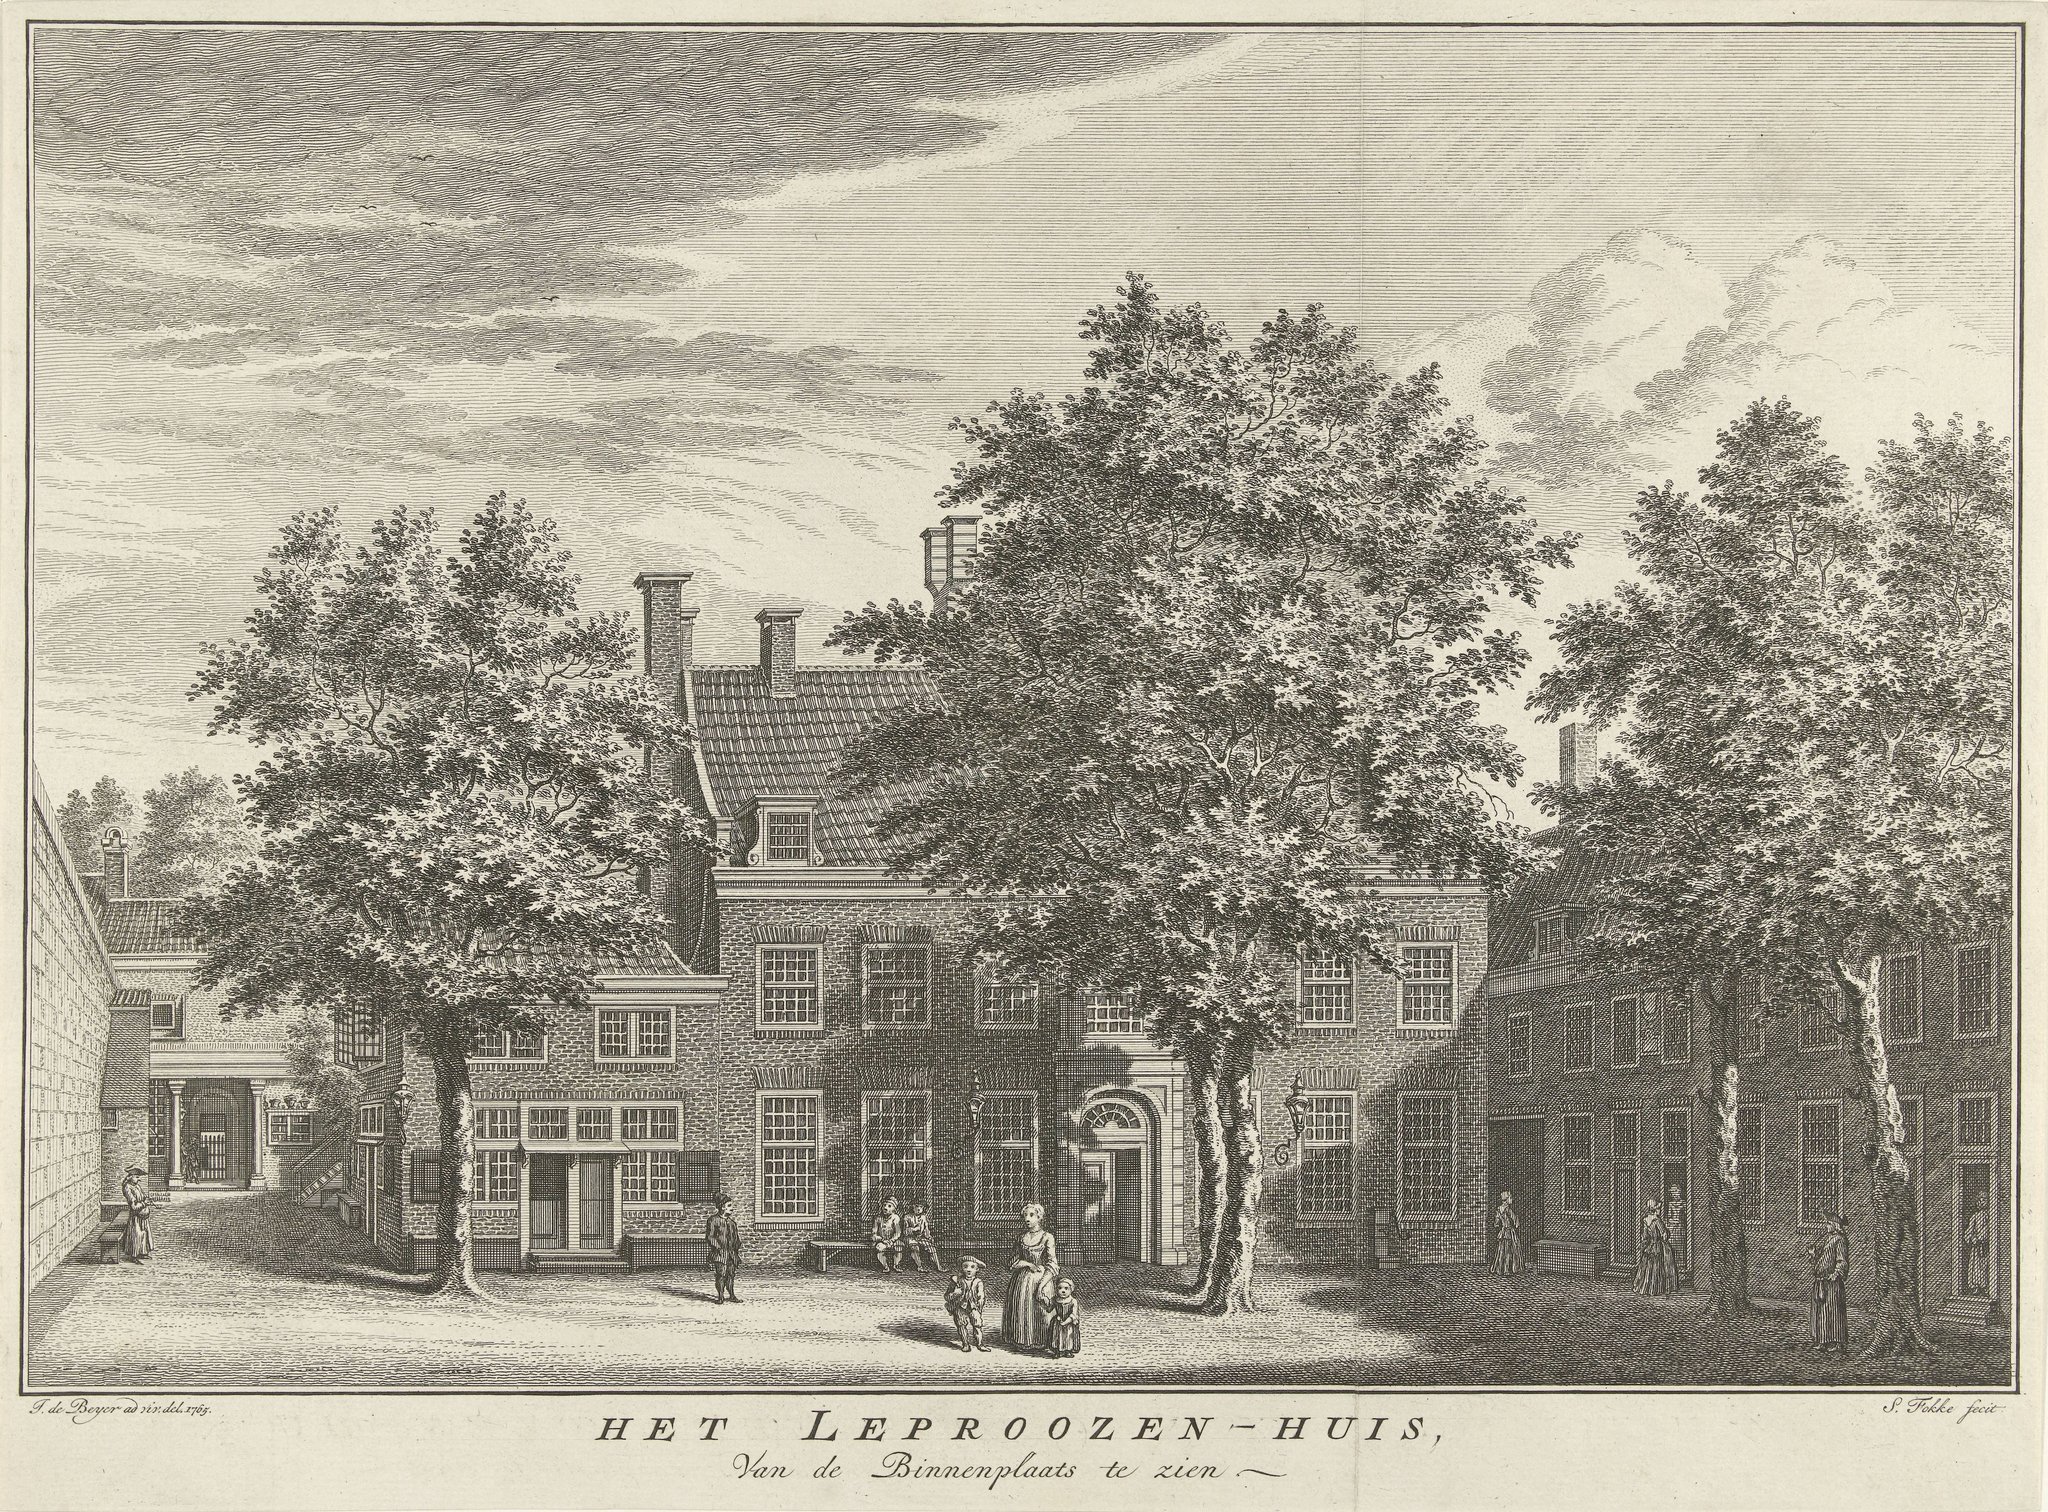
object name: print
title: Gezicht op de binnenplaats van het Leprozenhuis te Amsterdam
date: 1765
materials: paper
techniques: etching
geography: amsterdam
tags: leprosy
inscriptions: collector's mark: Lugt 2228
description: De binnenplaats van het Leprozenhuis te Amsterdam met bomen en enkele figuren.